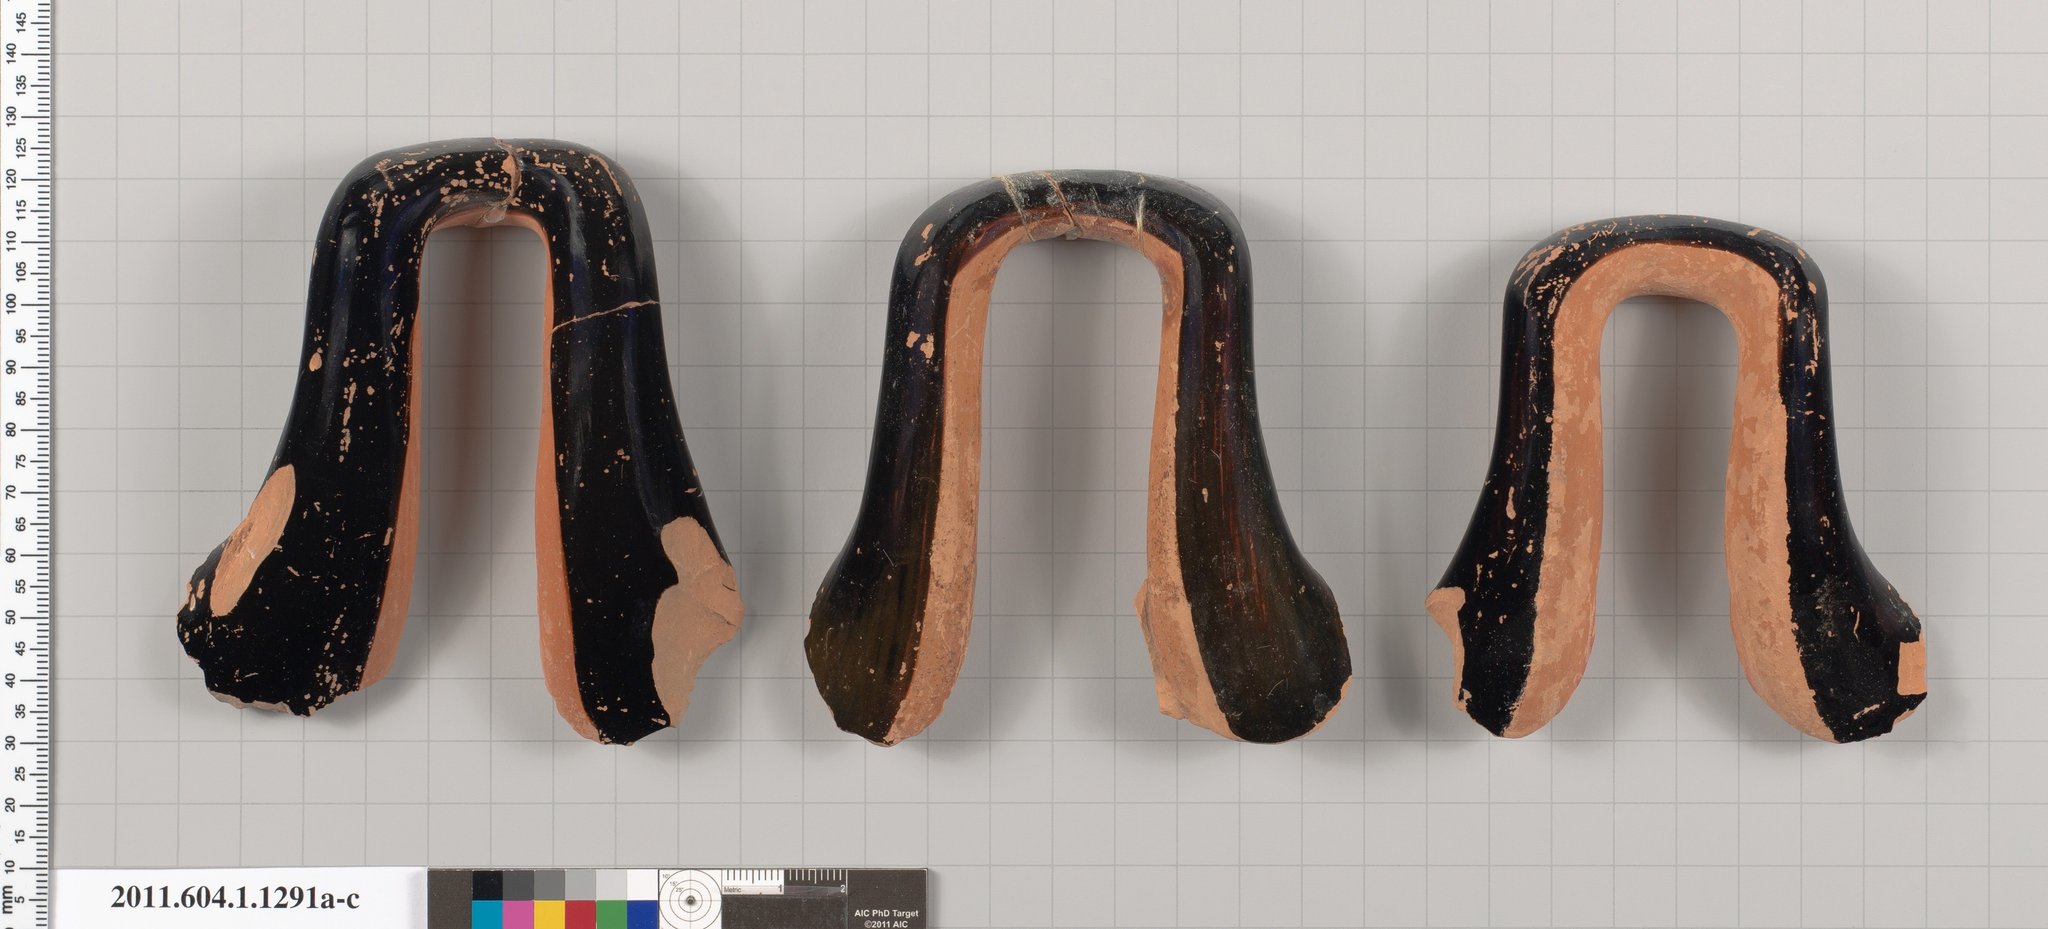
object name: kylix fragment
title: Terracotta fragments of kylikes (drinking cups)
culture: greek, attic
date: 500-401 BCE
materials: terracotta